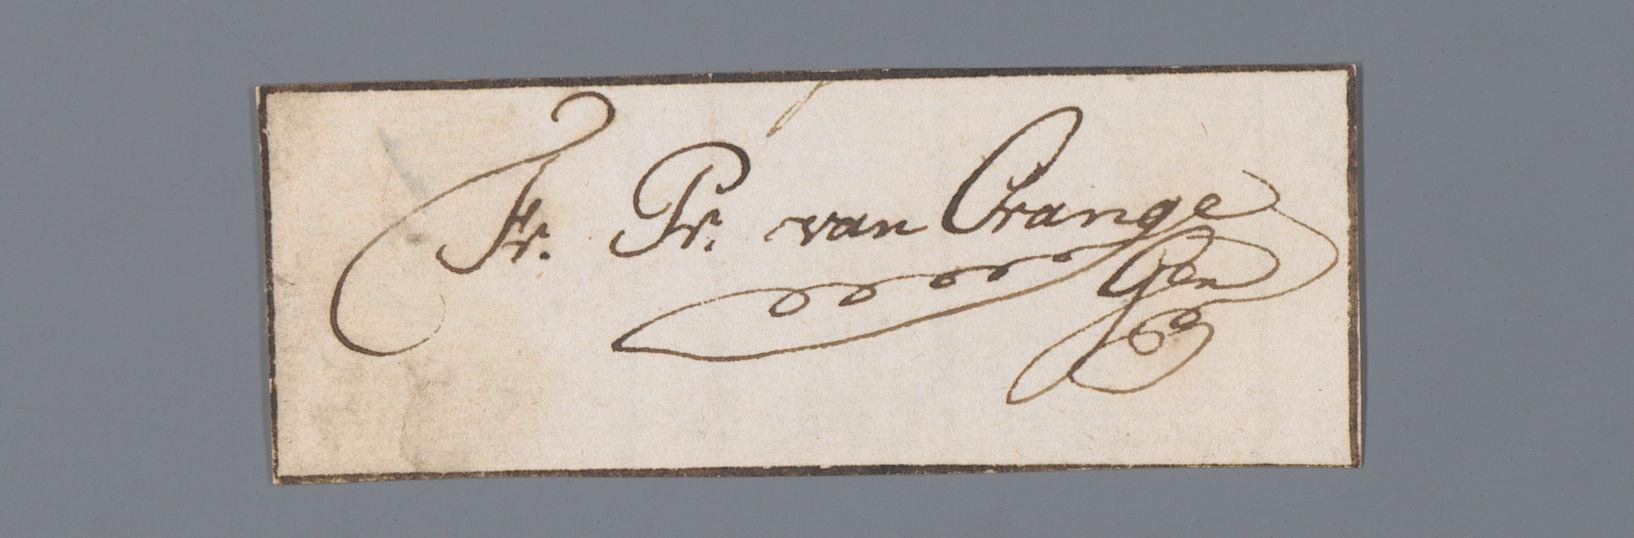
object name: document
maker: willem george frederik (prins van oranje-nassau)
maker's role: prins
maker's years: 1774-1799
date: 1775-1800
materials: ink, paper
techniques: writing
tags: the hague, willem george frederik (prins van oranje-nassau)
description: Handtekening in bruine inkt (van Willem George Frederik) op blaadje papier. Gesigneerd: Fr. Pr. van Orange.